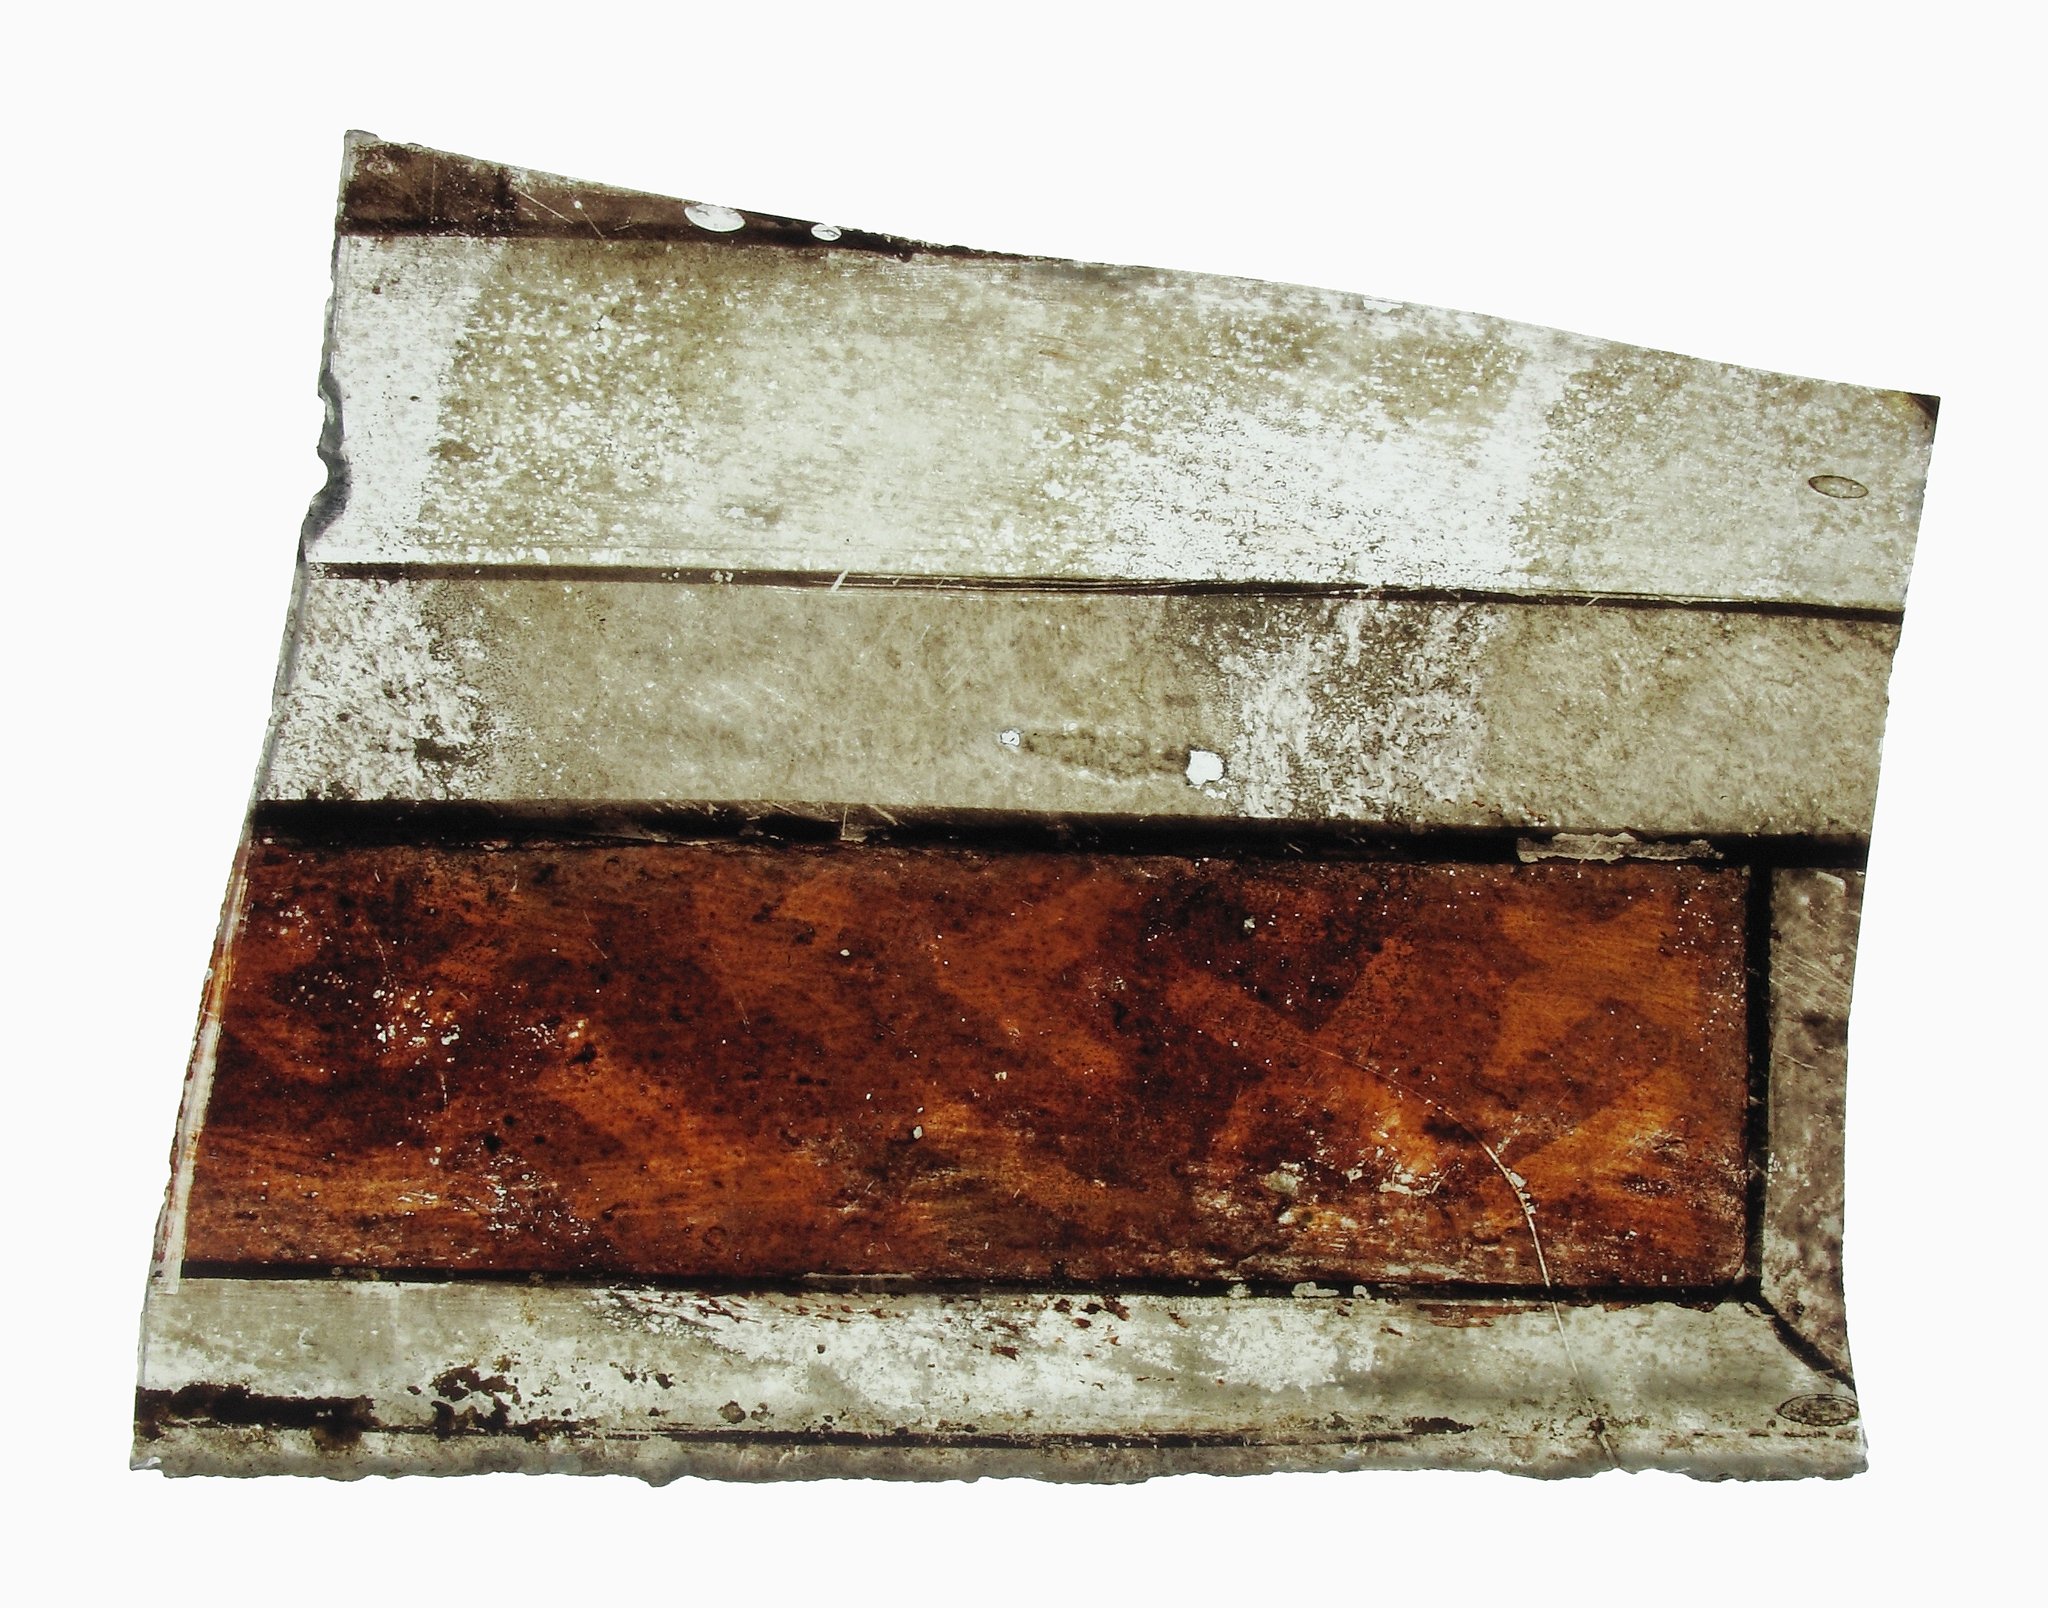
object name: fragment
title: Glass Fragment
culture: european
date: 1601-1700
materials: glass, metal